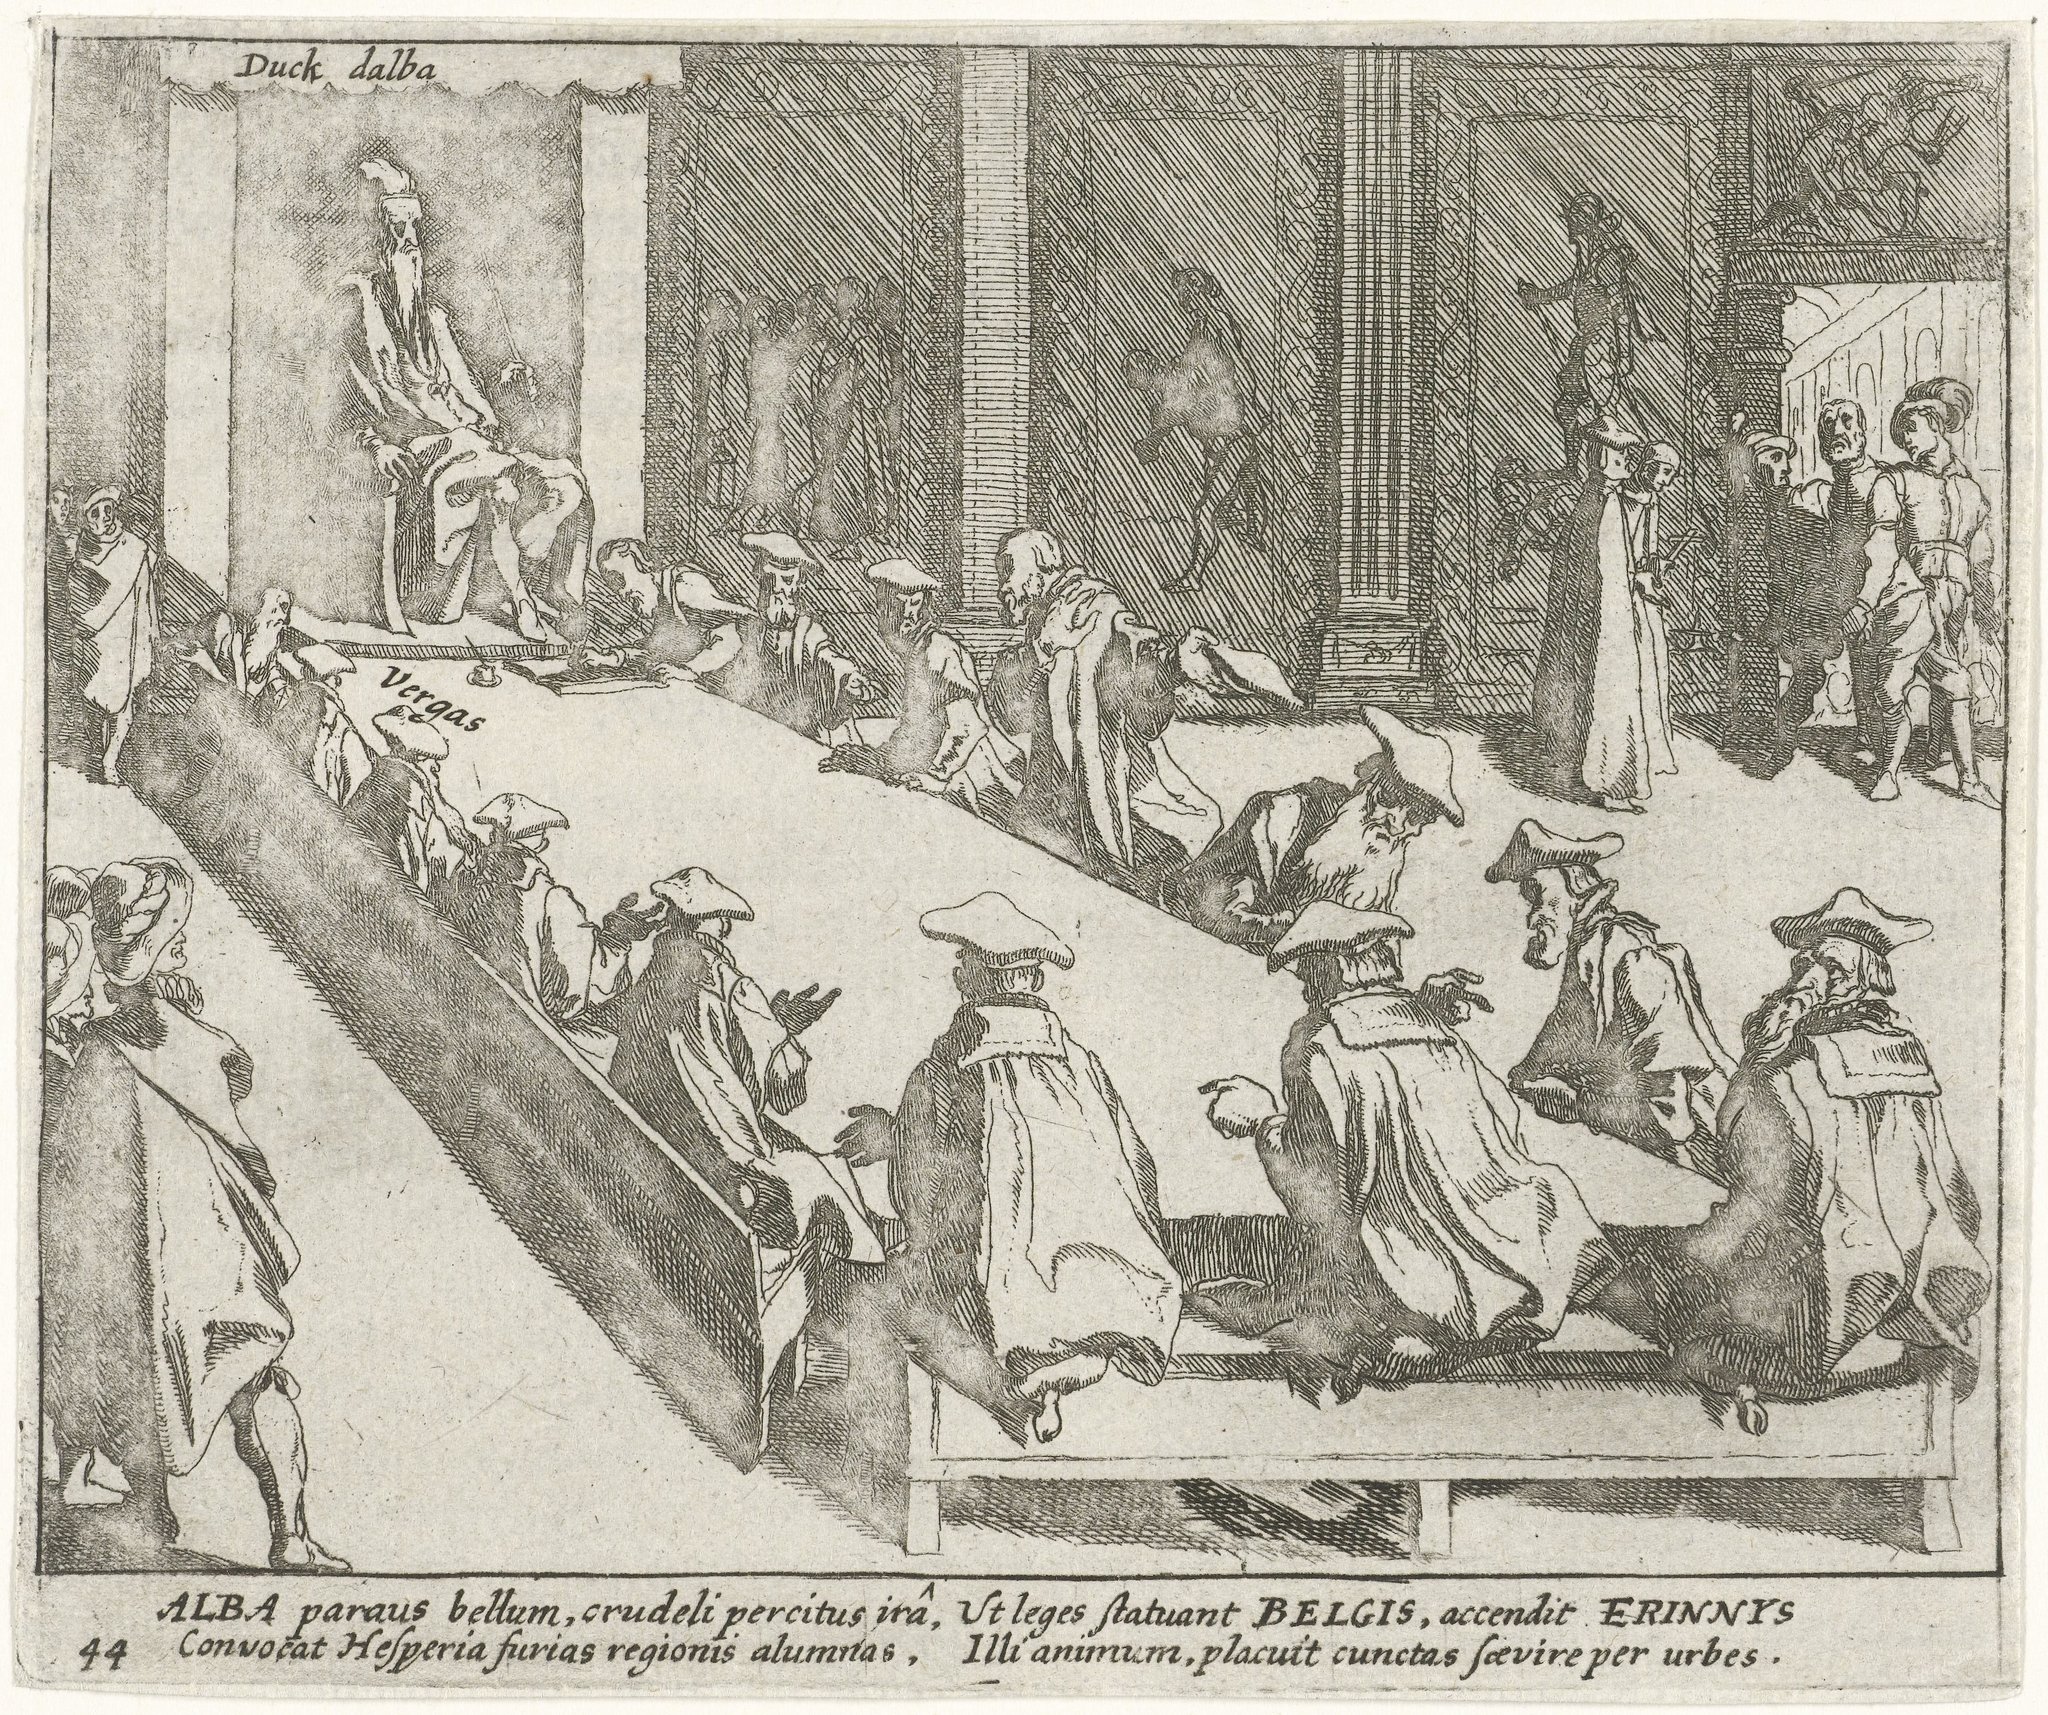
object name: print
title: Zitting van de Spaanse Bloedraad, 1567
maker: simon frisius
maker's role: print maker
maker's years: 1570-1628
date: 1613-1615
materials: paper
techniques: etching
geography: northern netherlands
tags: fernando álvarez de toledo (3rd duke of alba), court session (court of justice)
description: Zitting van de Raad van Beroerten, bijgenaamd de Bloedraad, voorgezeten door de hertog van Alva gezeten op een troon met de gerechtsroede in de hand, 1567. Aan de muren van het interieur hangen wandkleden. Met onderschrift van 4 regels in het Latijn. Genummerd: 44. Bedrukt op achterzijde met tekst in het Latijn.